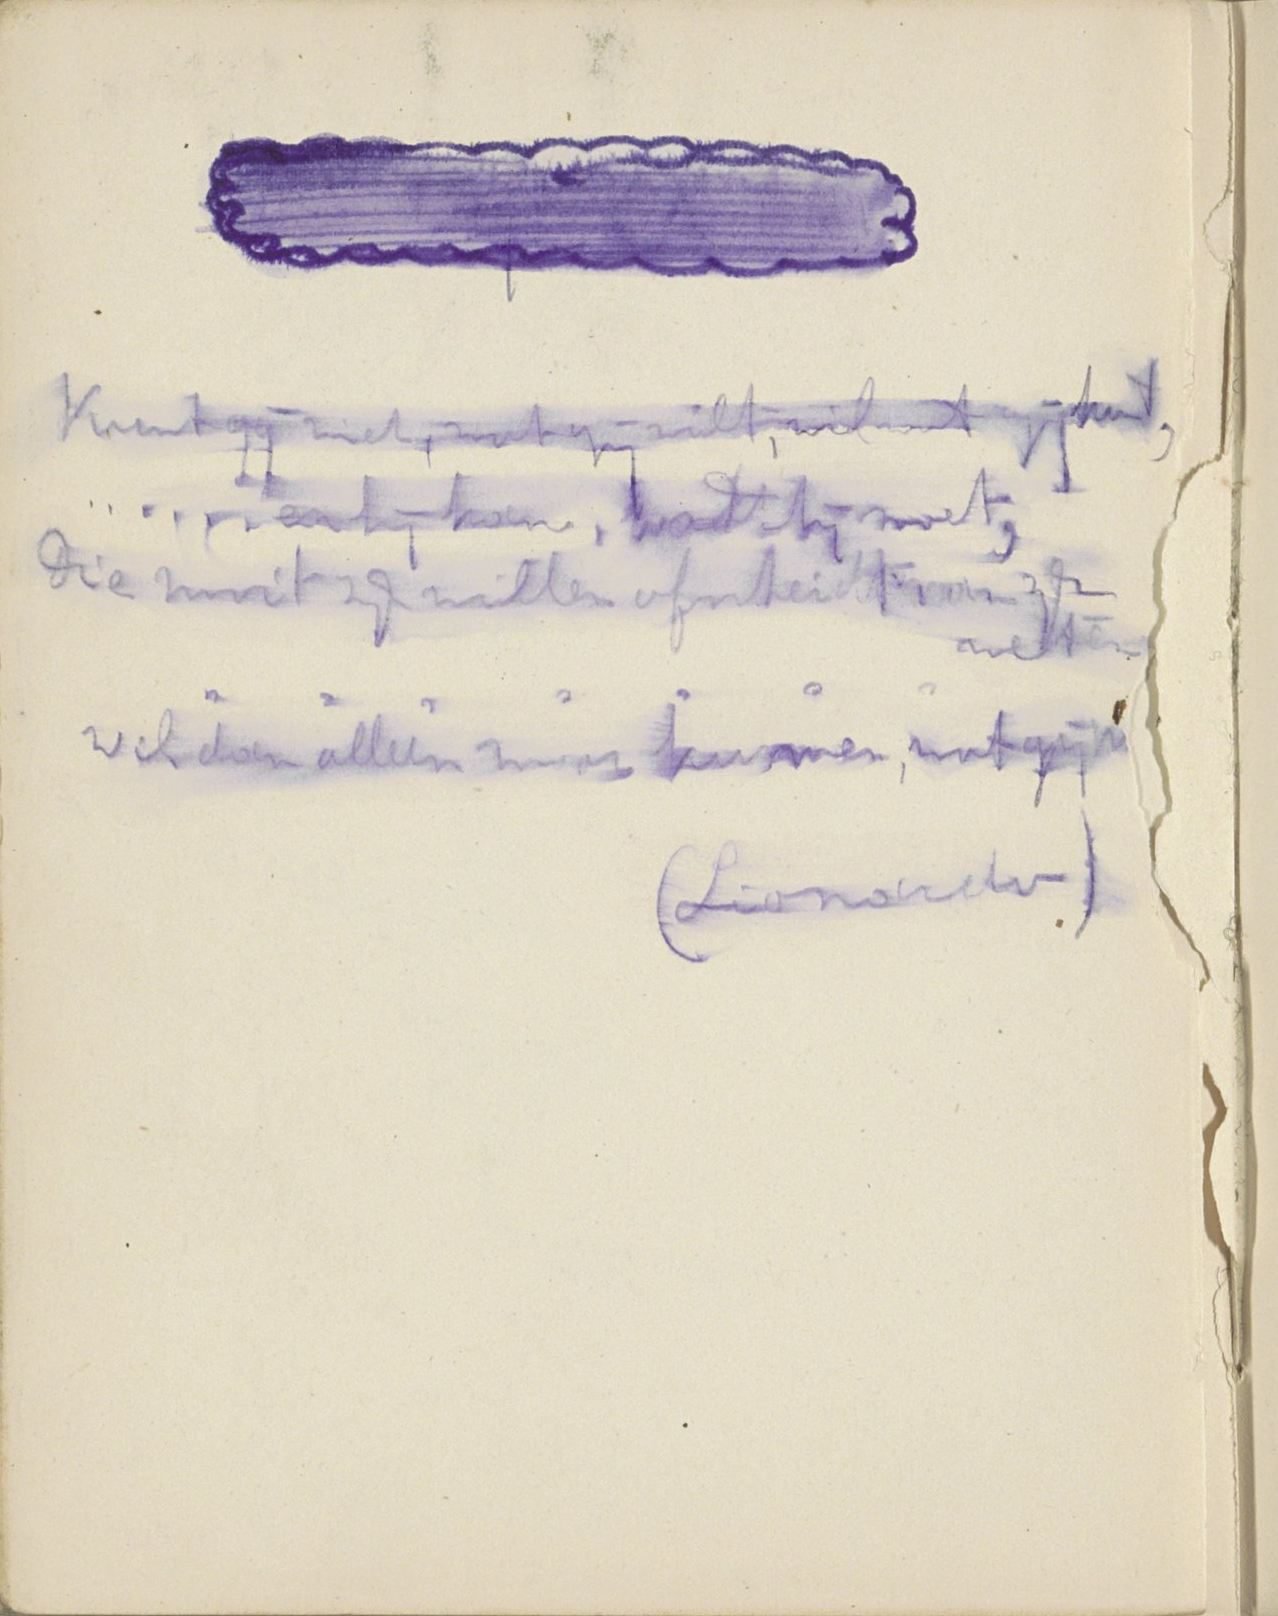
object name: sketchbook leaf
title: Notitie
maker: reijer stolk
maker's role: draughtsman, print maker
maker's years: 1896-1945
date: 1906-1945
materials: ink, paper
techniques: pen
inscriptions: annotation: ‘[...]’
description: Blad 68 verso uit een schetsboek met 69 bladen.